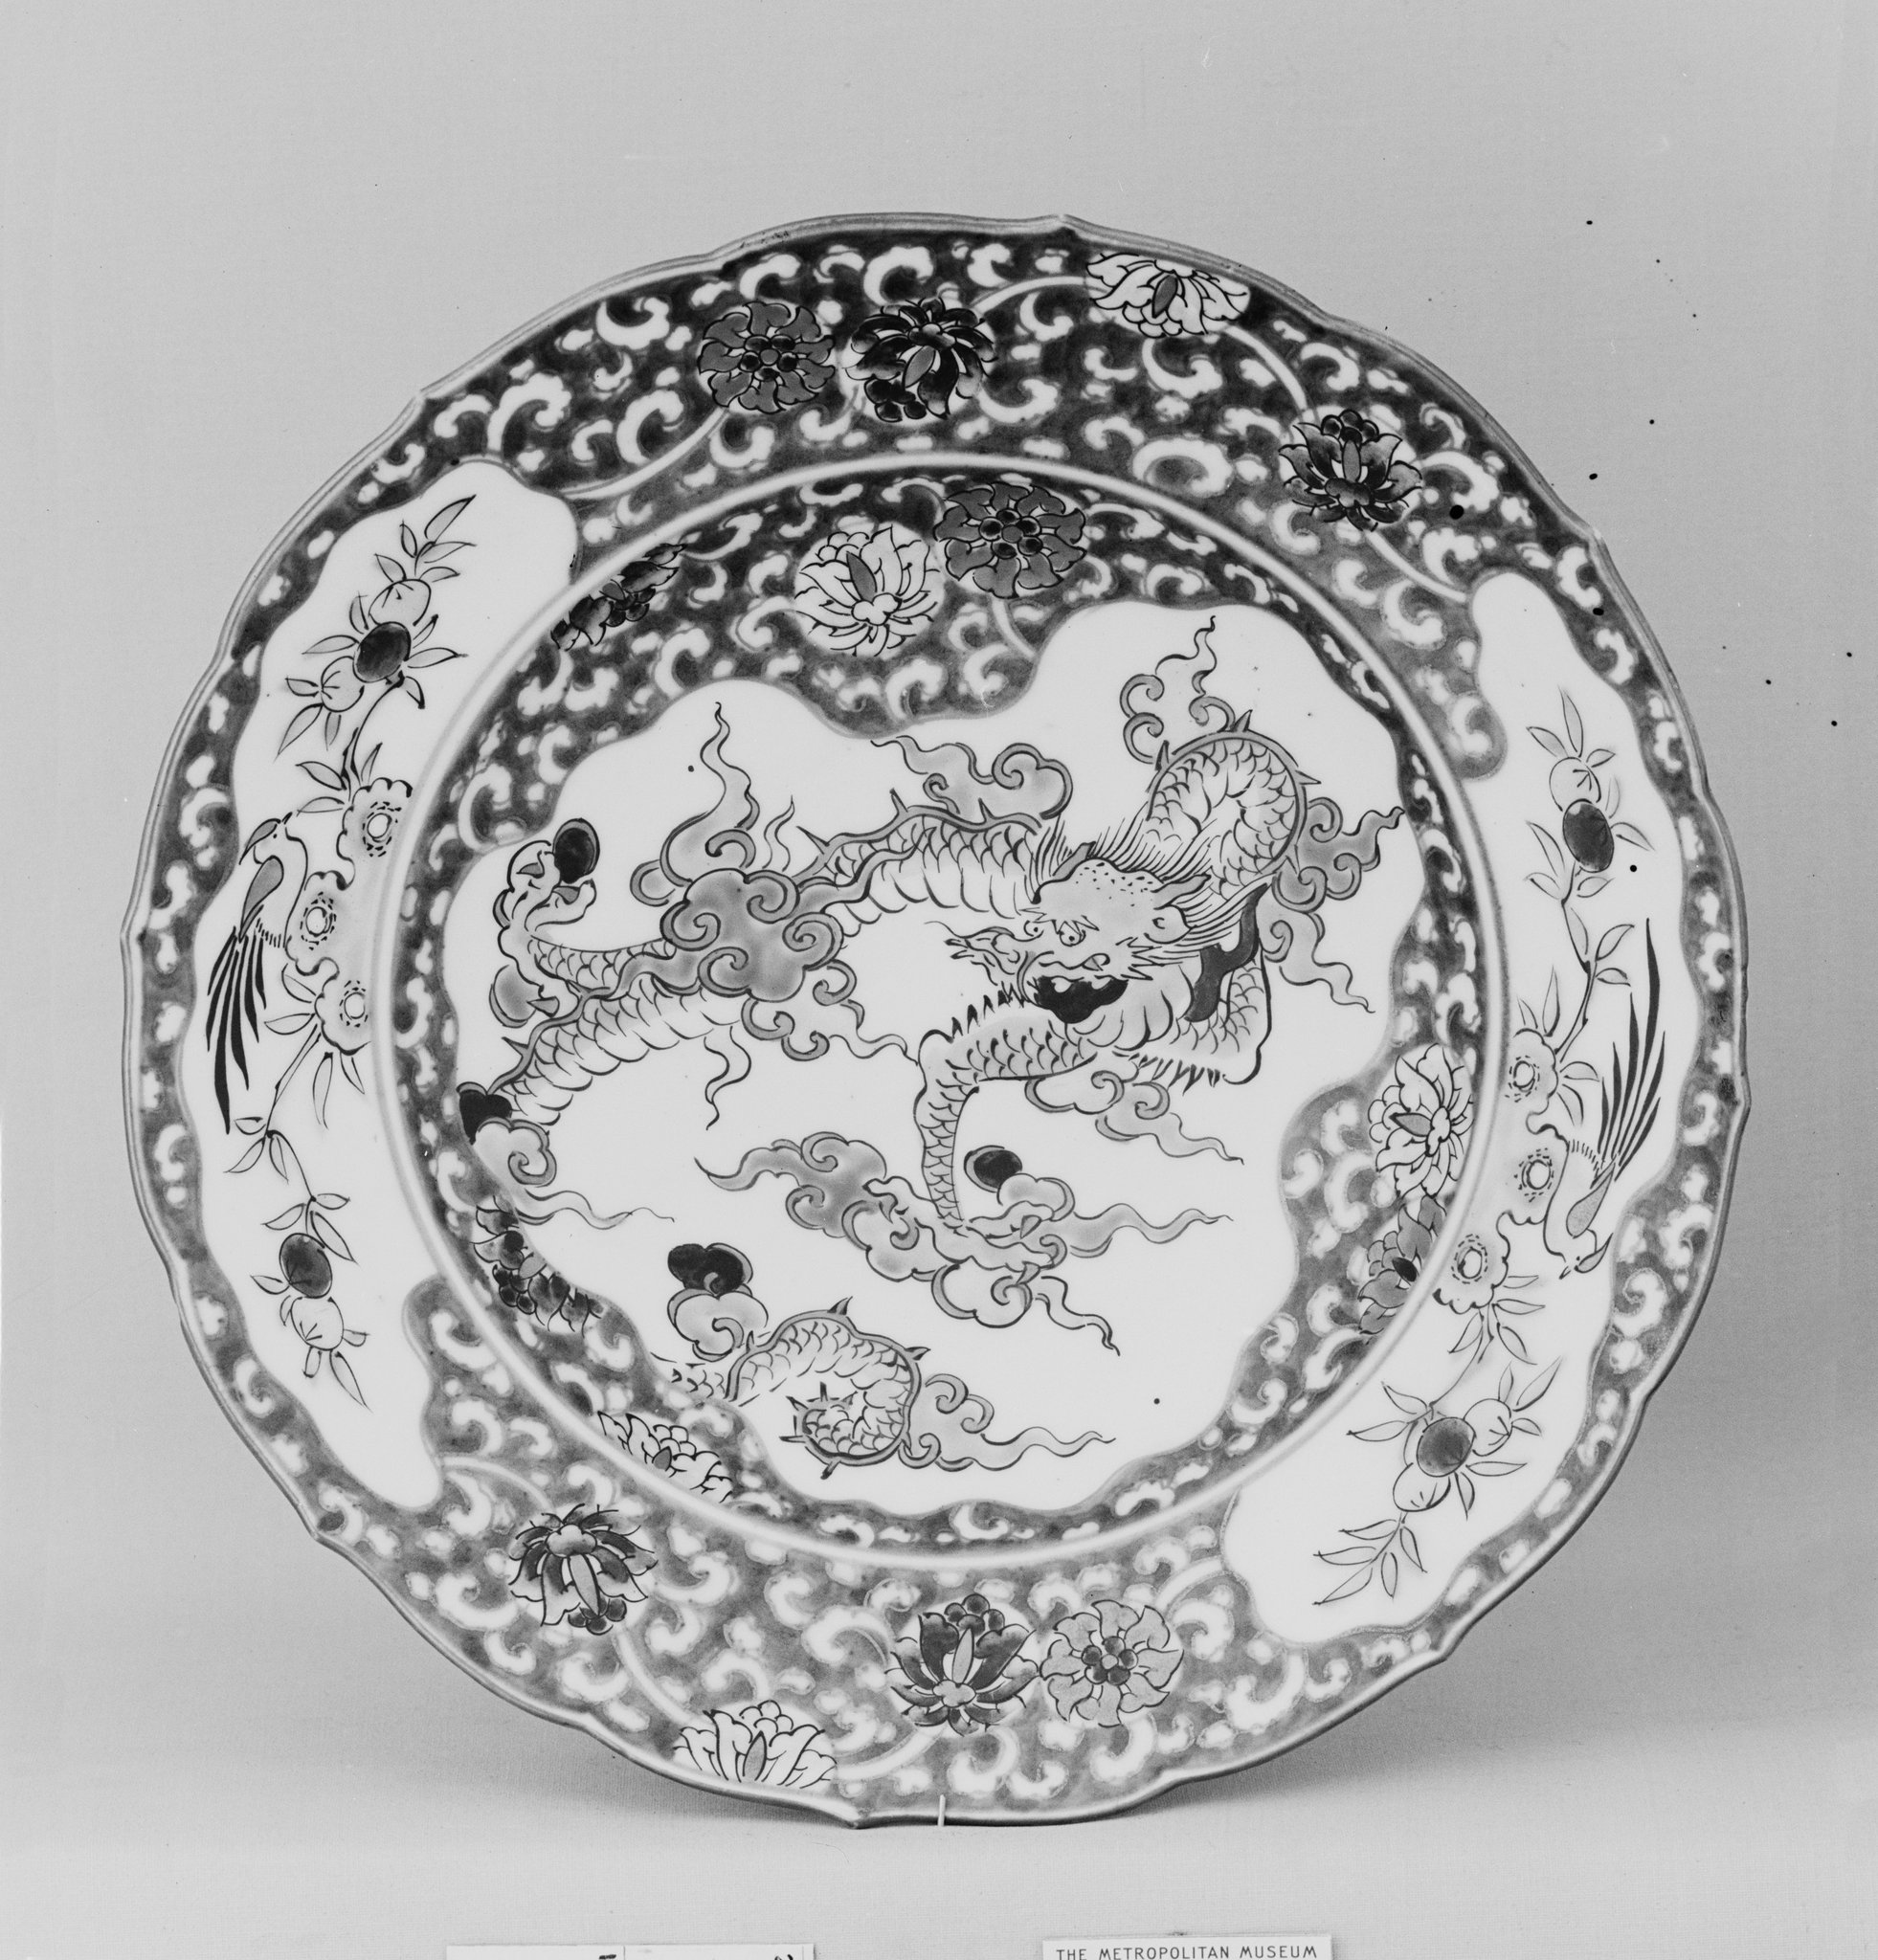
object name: plate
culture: japanese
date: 1800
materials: porcelain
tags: dragons